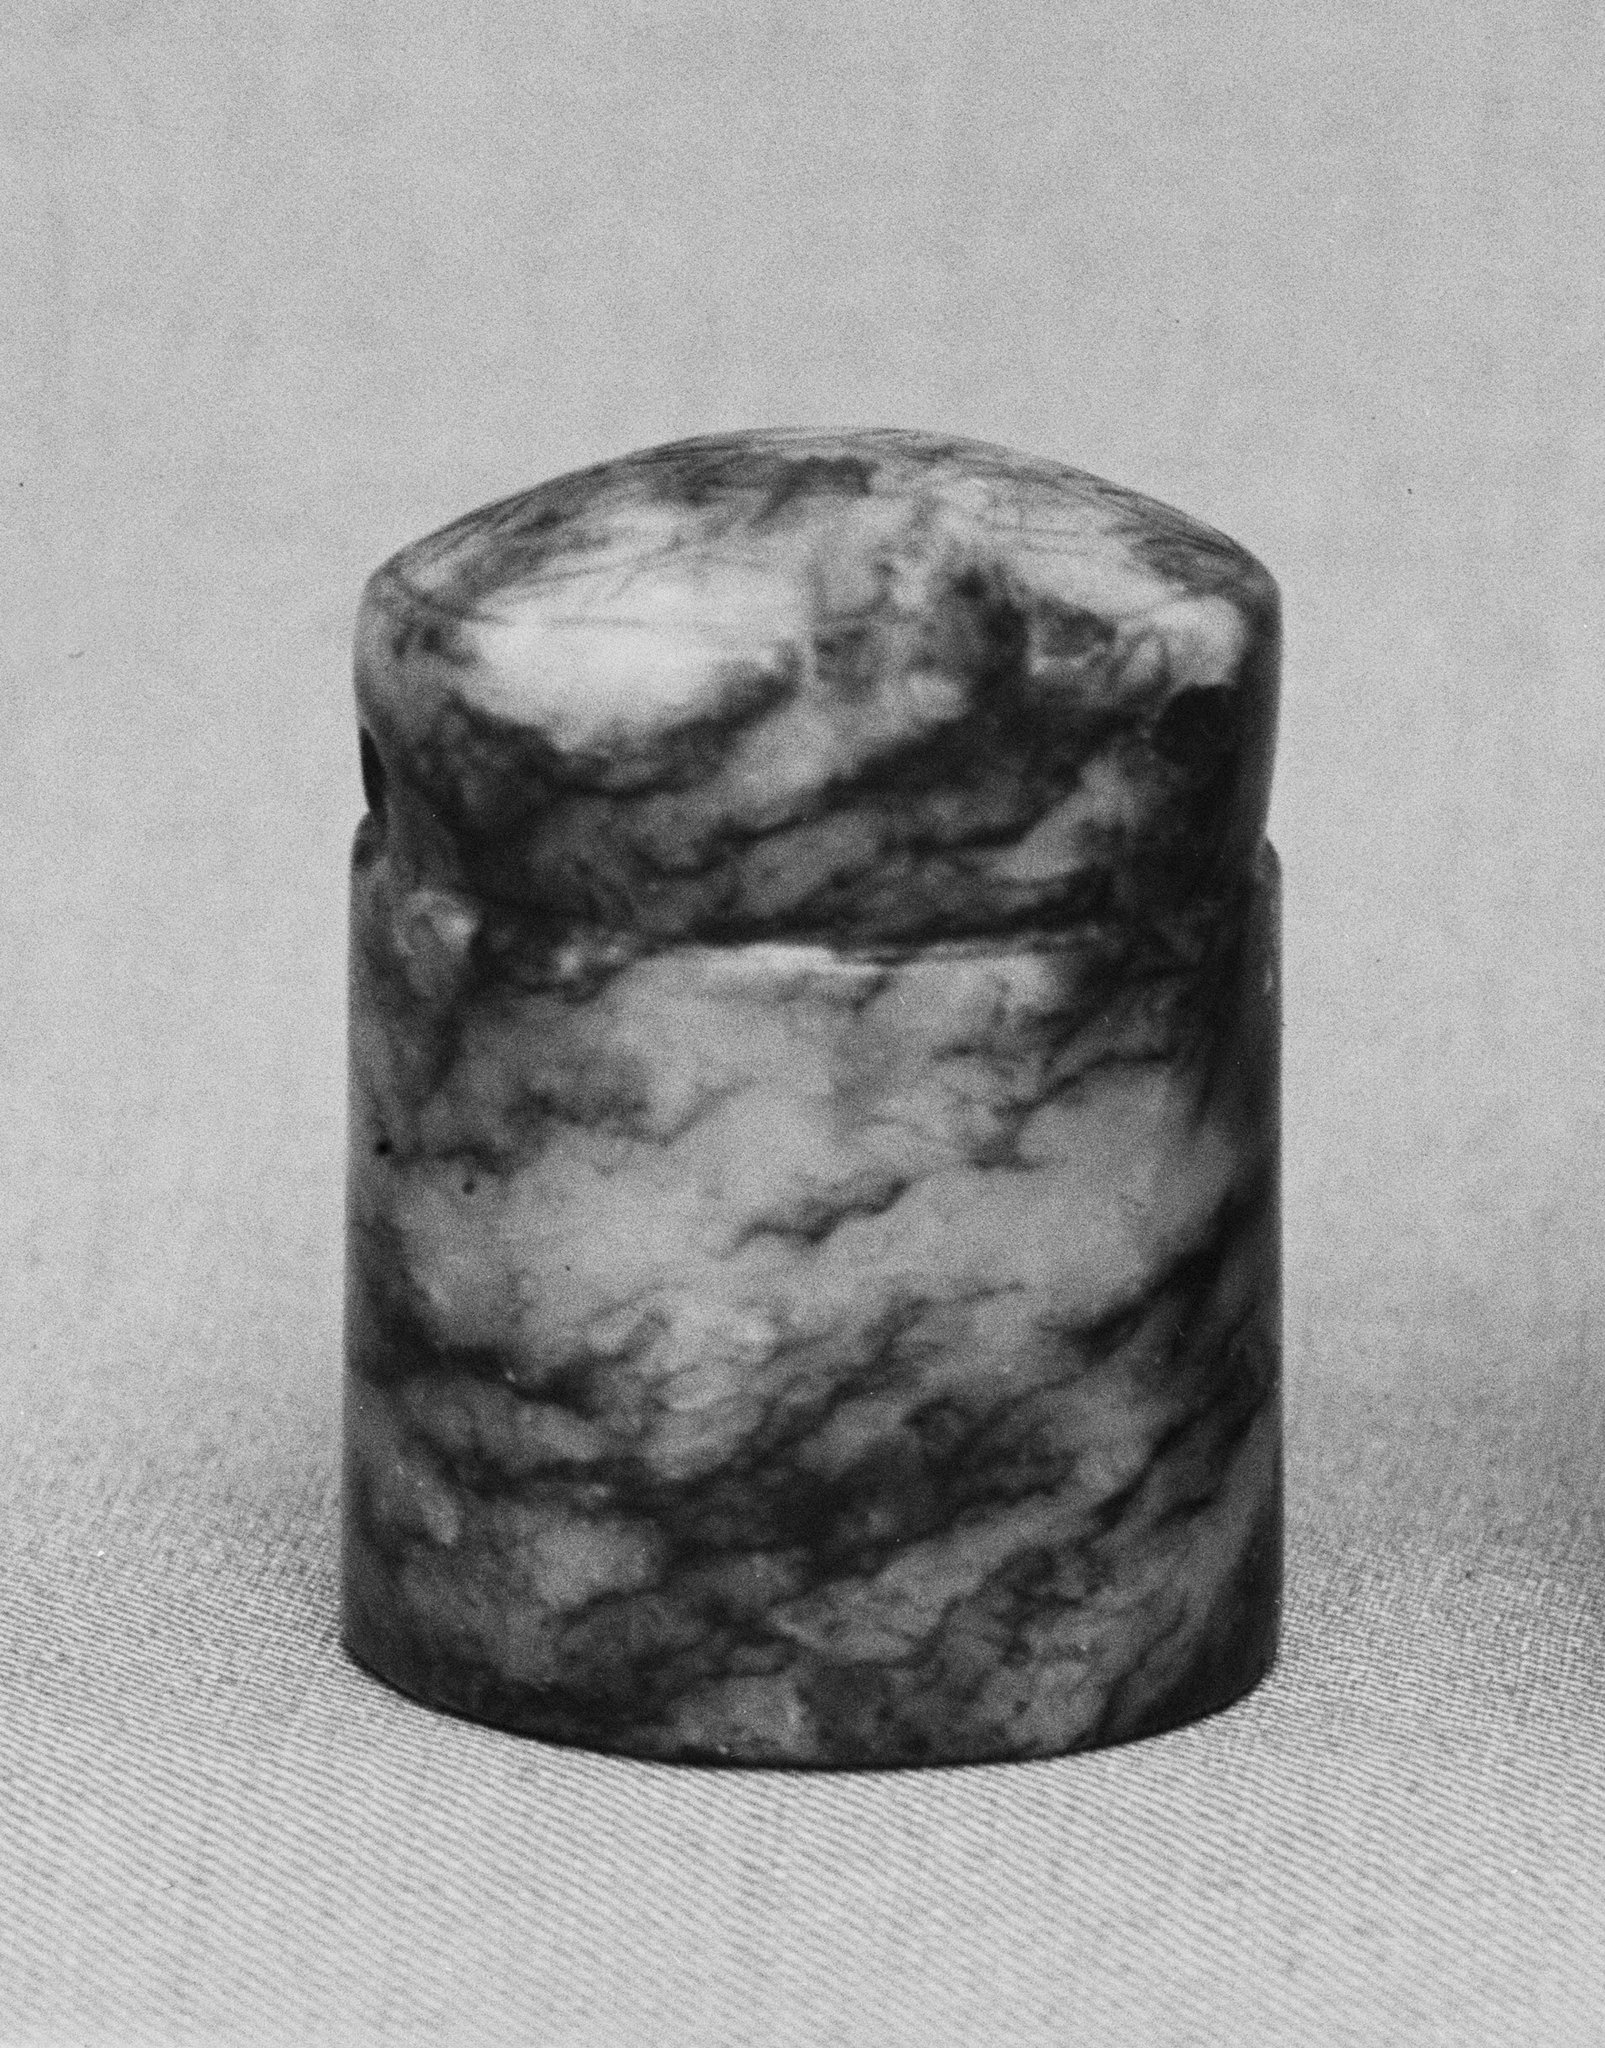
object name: seal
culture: chinese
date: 206 BCE-220 CE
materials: jade